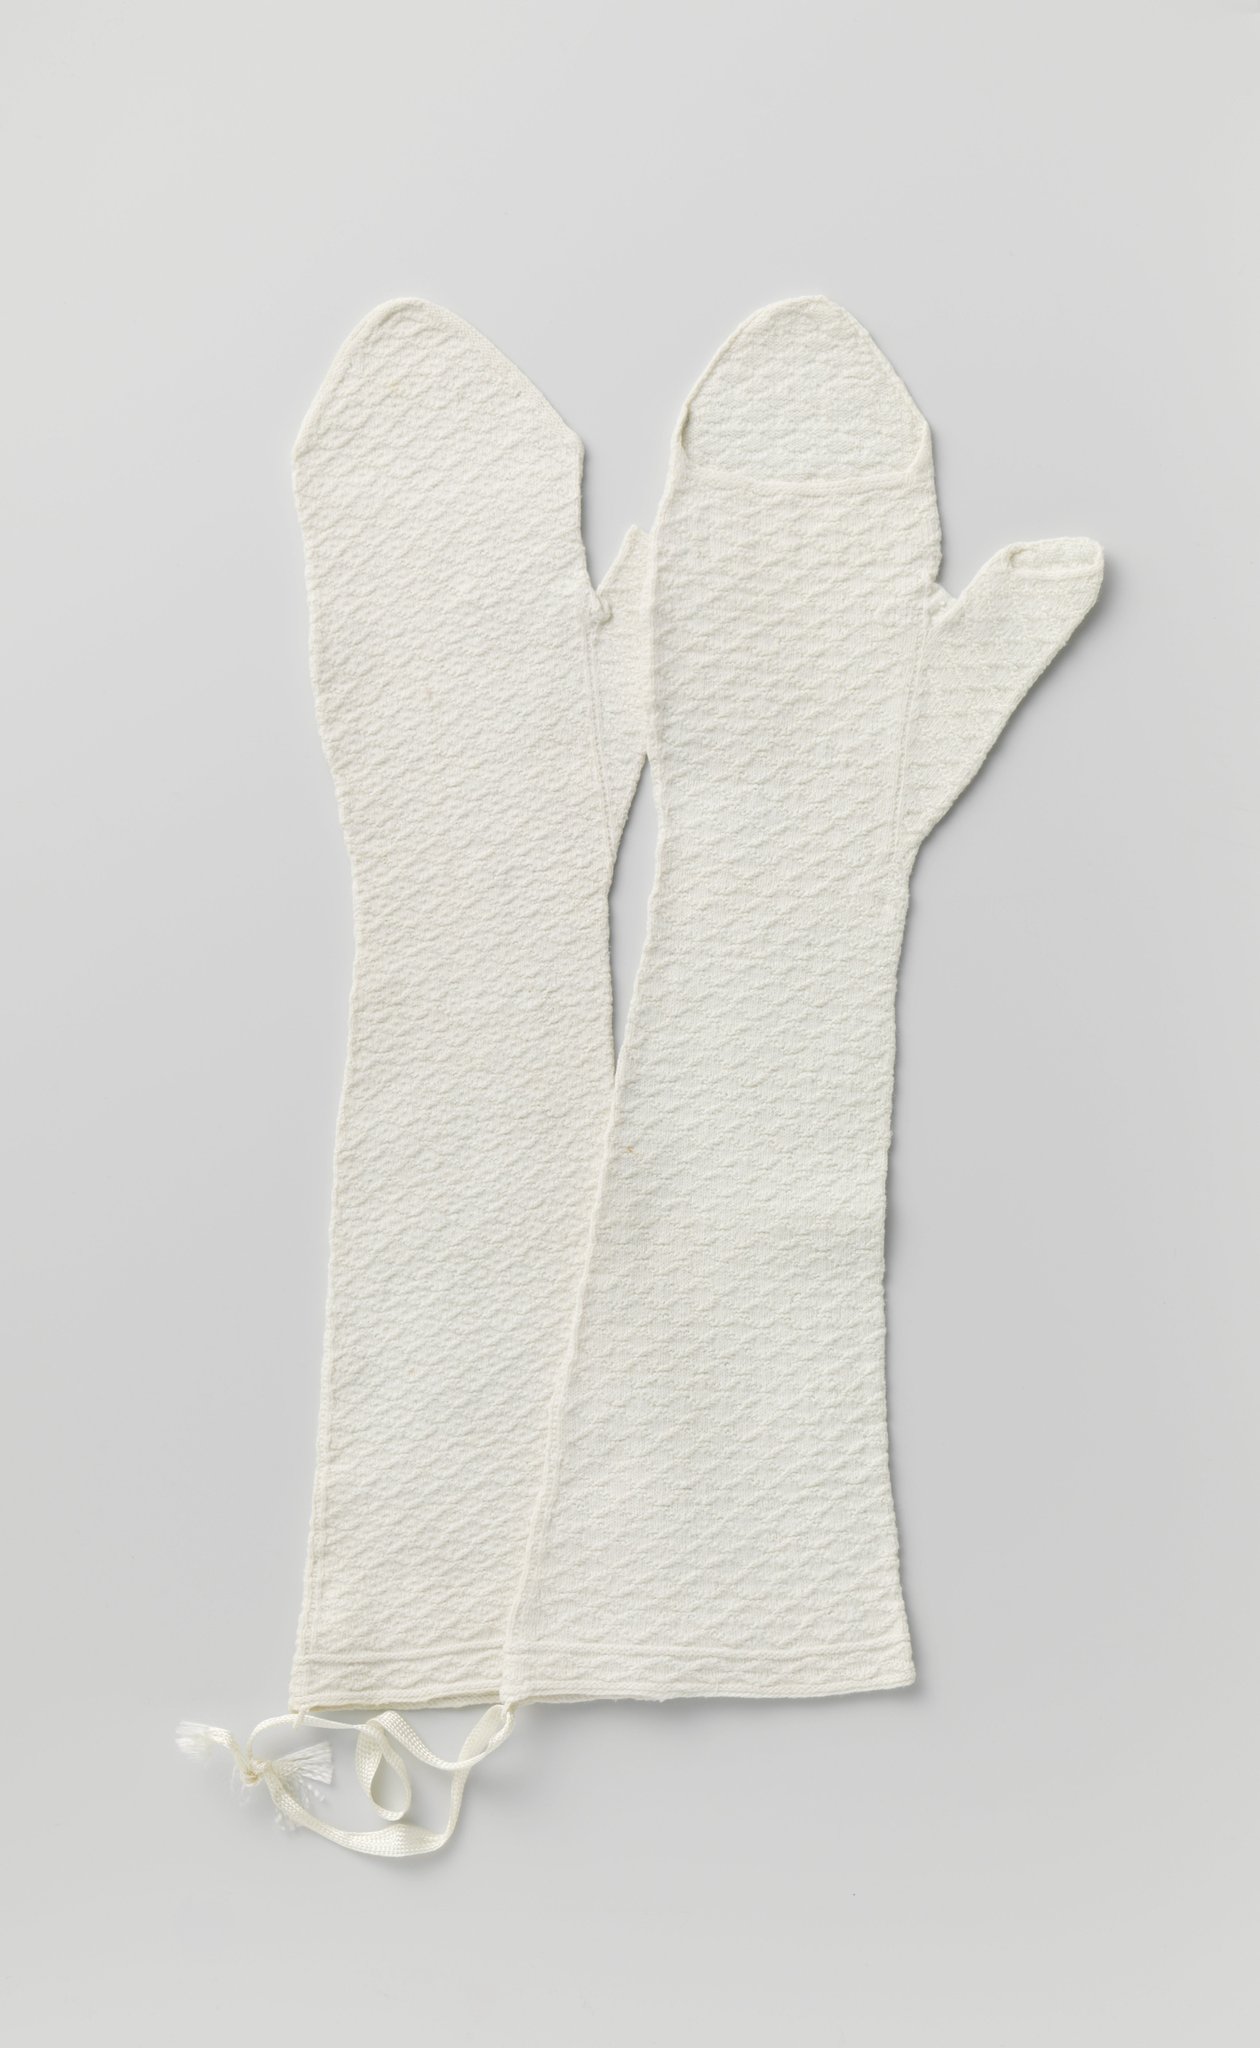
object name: mitt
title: Mitaine van witte gebreide katoen met open duim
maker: Anonymous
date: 1730-1800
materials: cotton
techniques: knitting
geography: western europe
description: Linkermitaine van witte gebreide katoen in ruitjespatroon met een open duim. De handrug heeft een onversierde gladde rand.